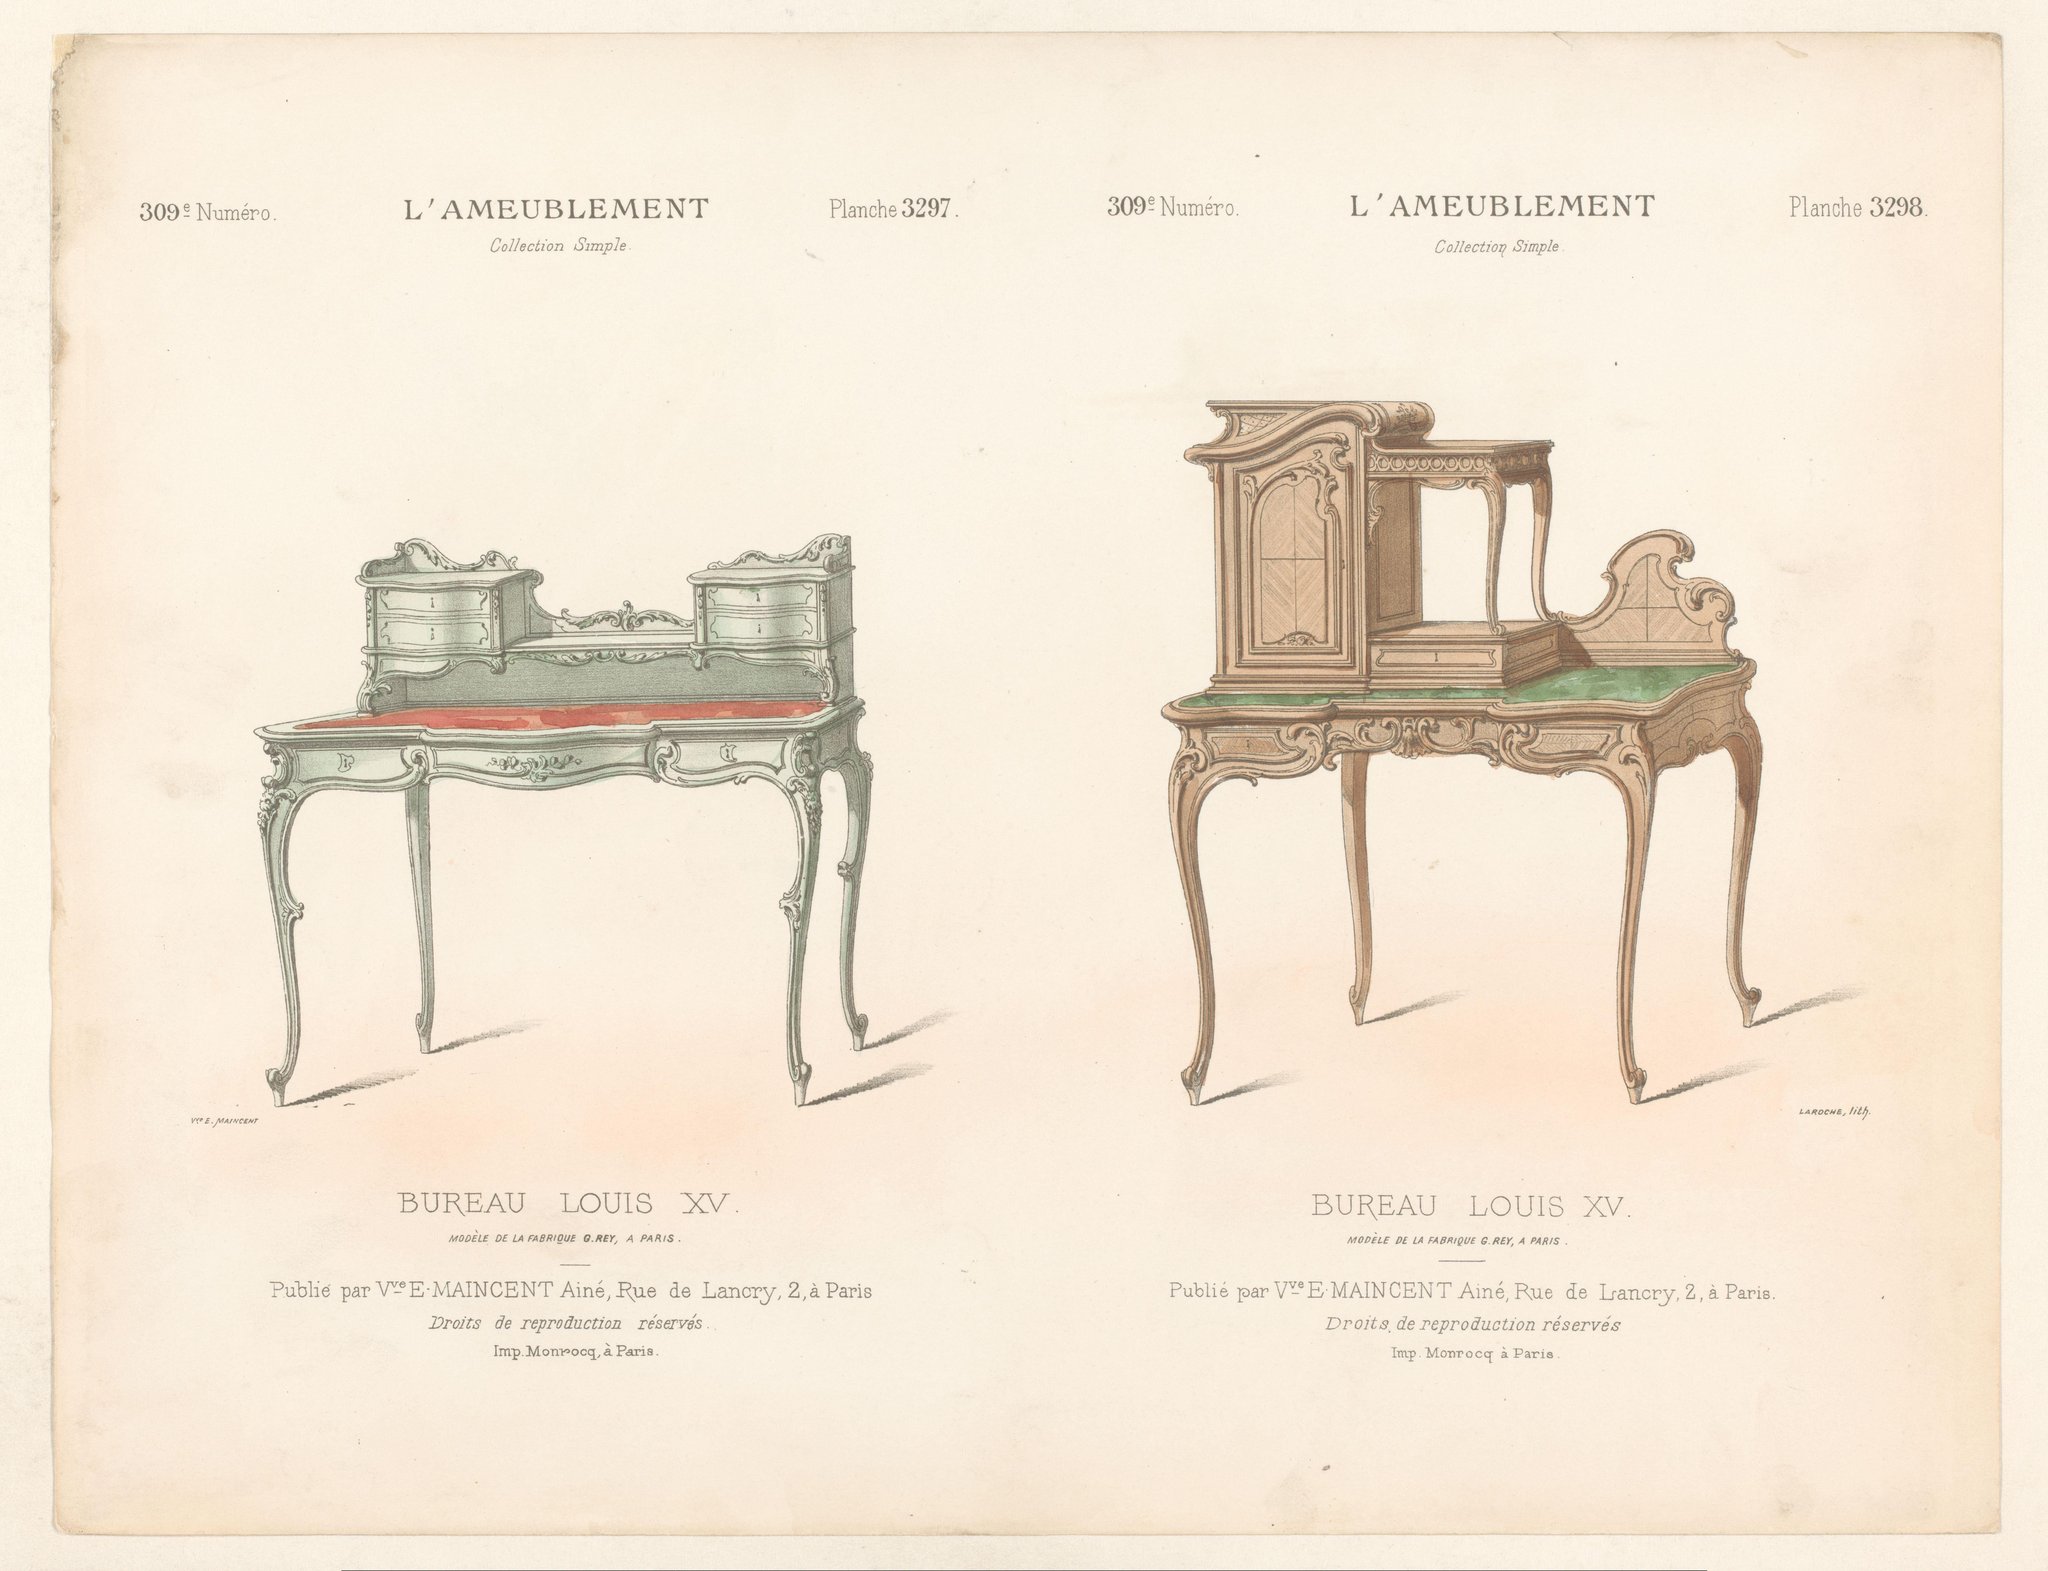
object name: print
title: L'Ameublement / Collection Simple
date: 1895-1910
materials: paper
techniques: hand coloring, lithograph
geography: paris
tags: writing-table, writing-desk, decorative furniture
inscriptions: : ‘Droits de reproduction réservés.’